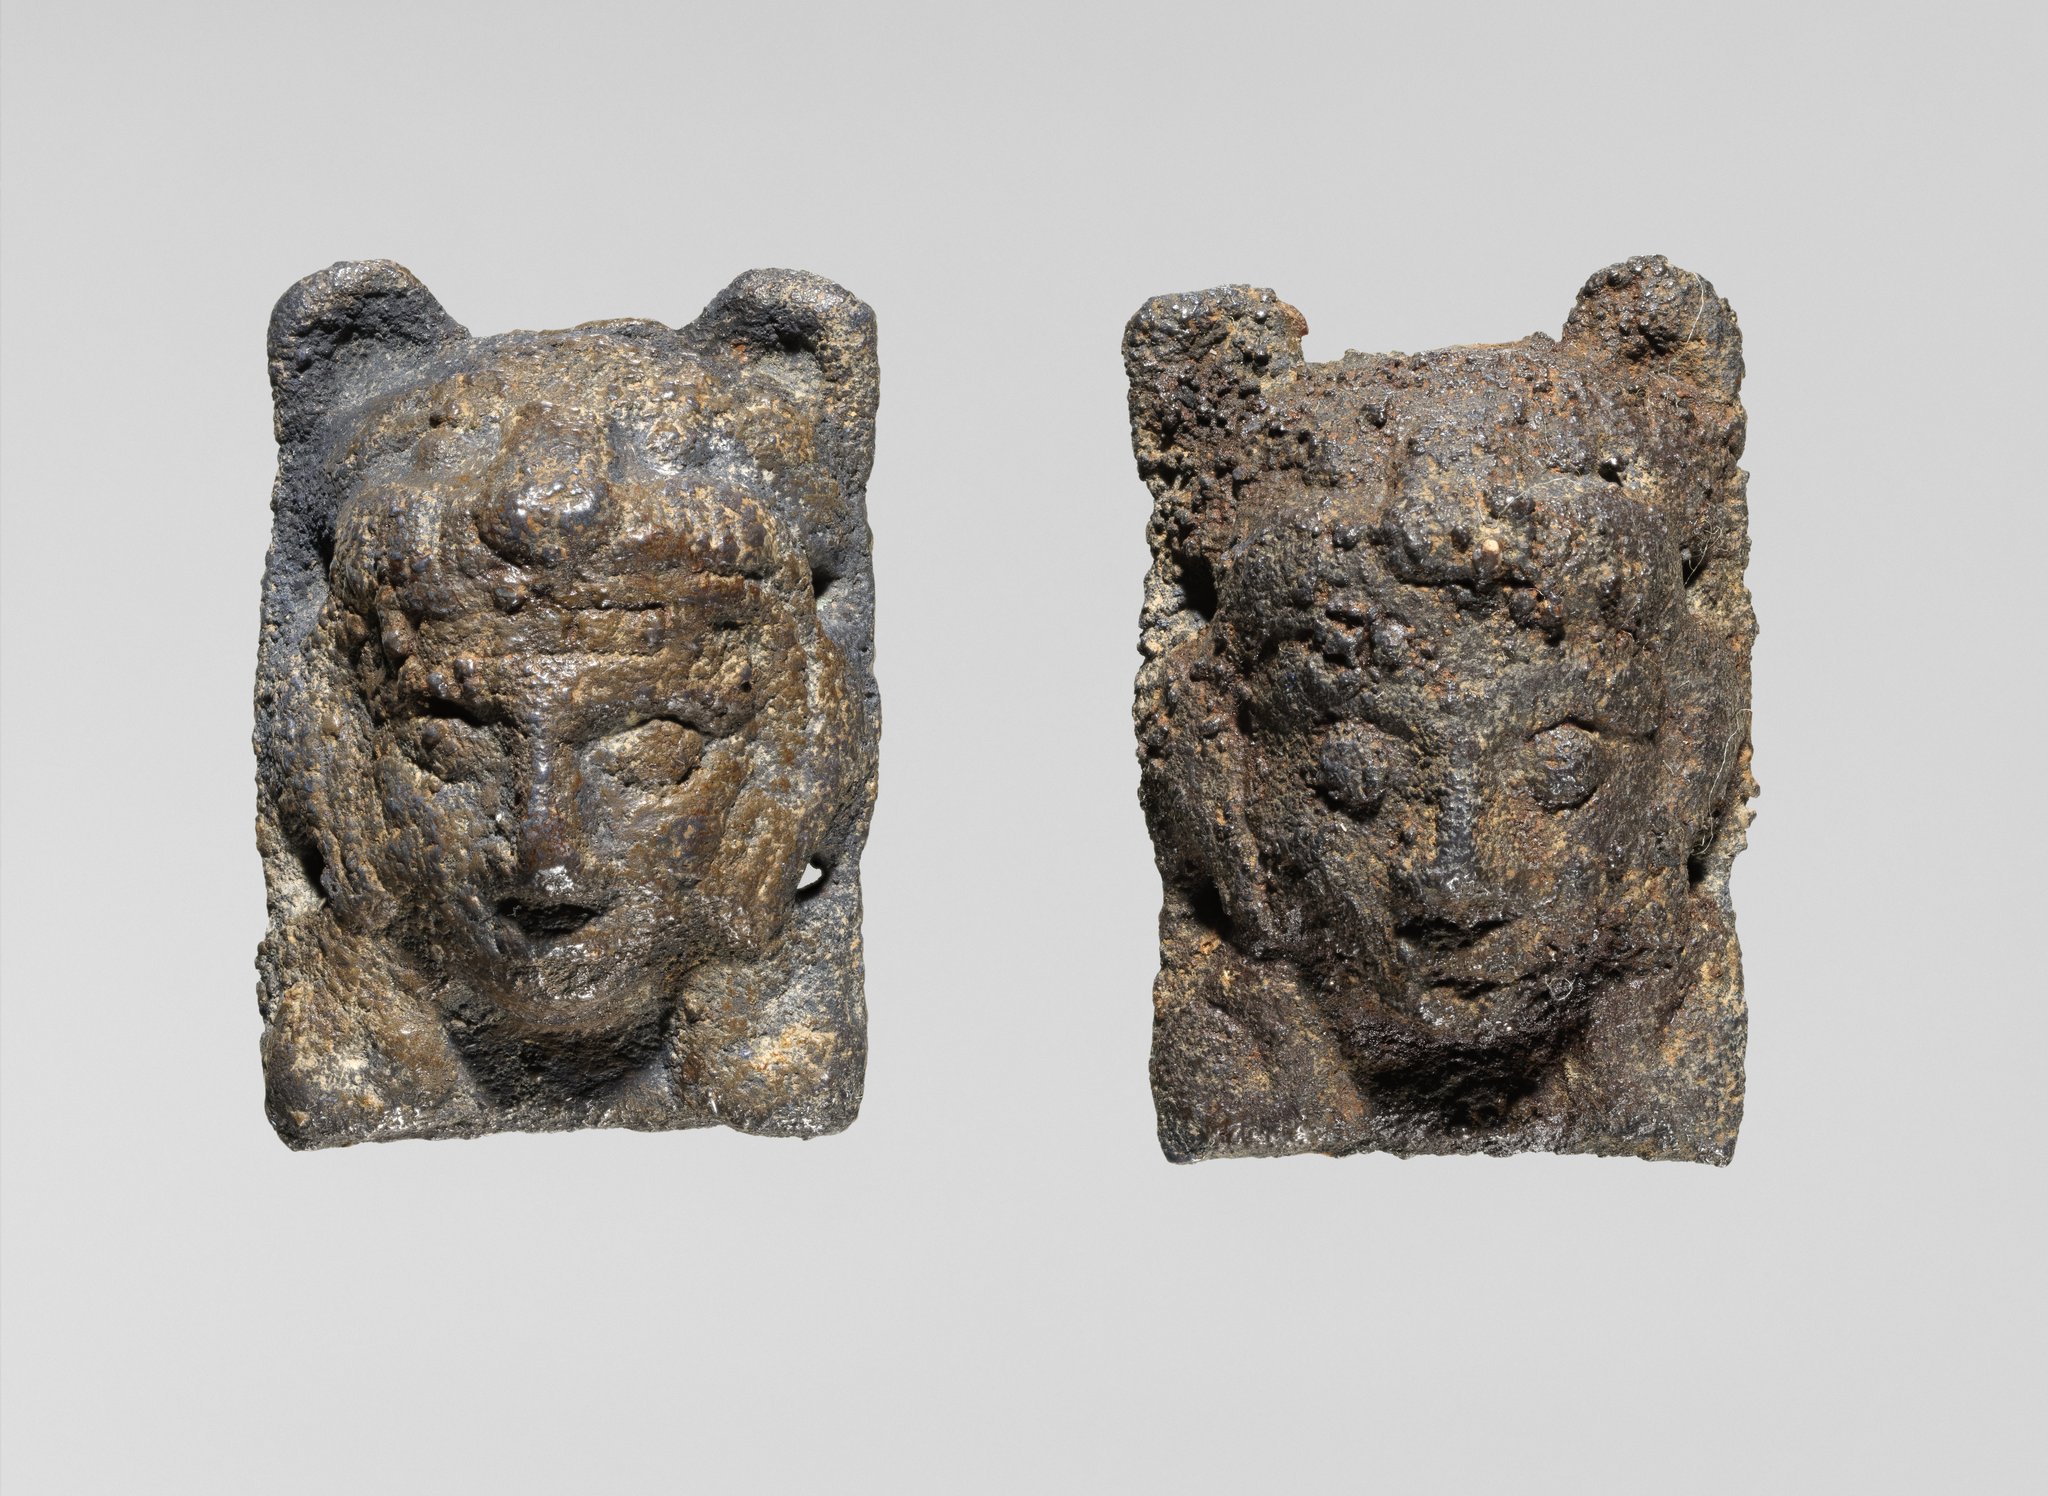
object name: bead with female head from a necklace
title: Silver appliqués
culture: cypriot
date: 500-301 BCE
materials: silver